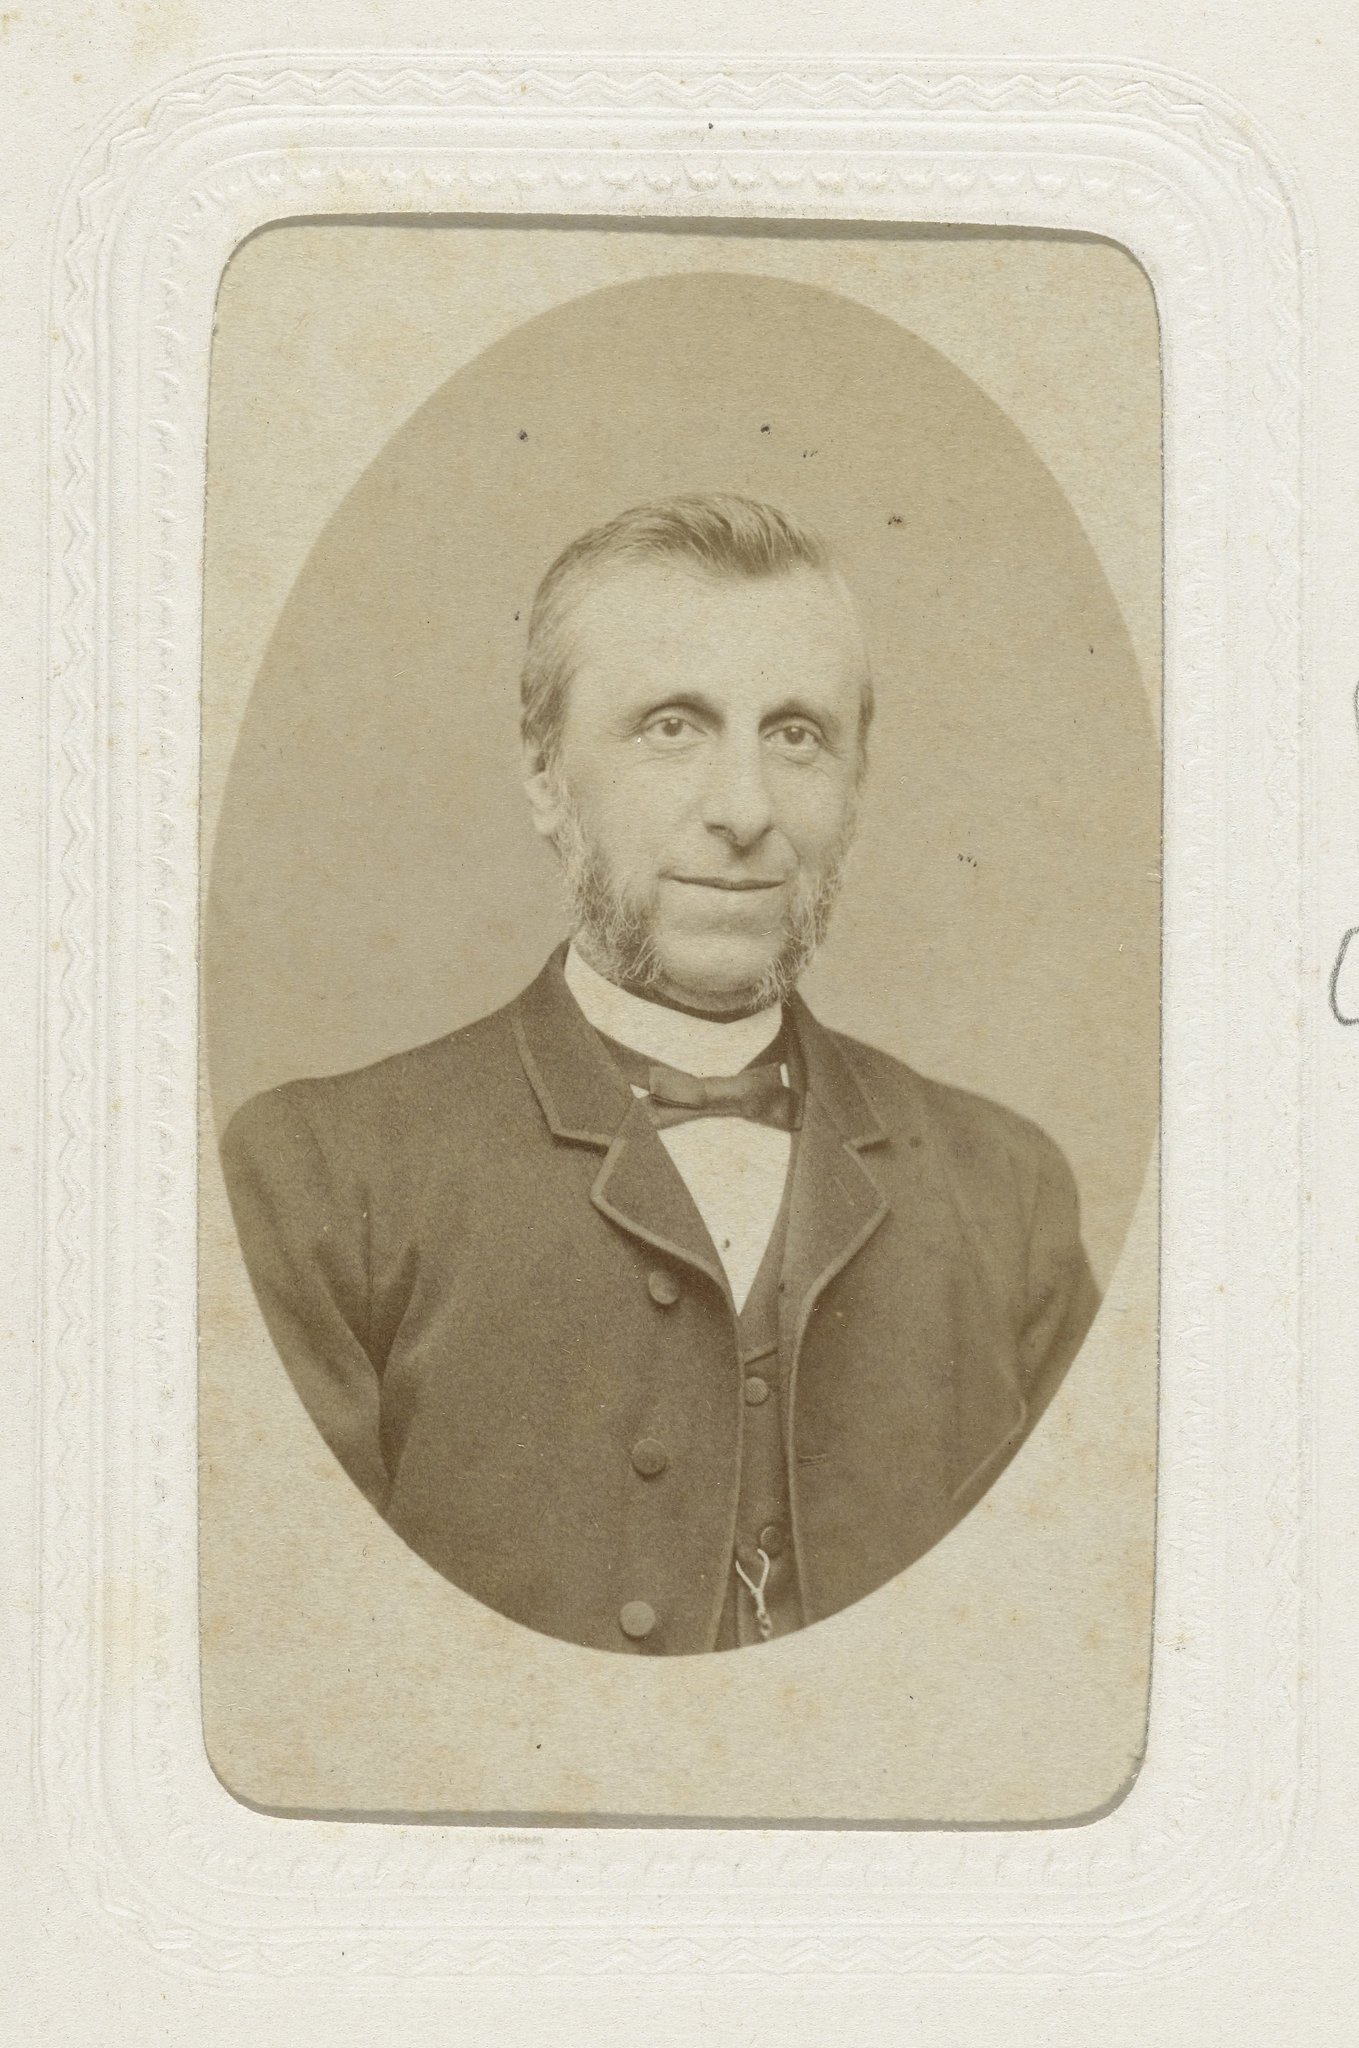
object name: carte de visite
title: Studioportret van een man met grote bakkebaarden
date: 1863-1866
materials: cardboard, paper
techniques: albumen print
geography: amsterdam